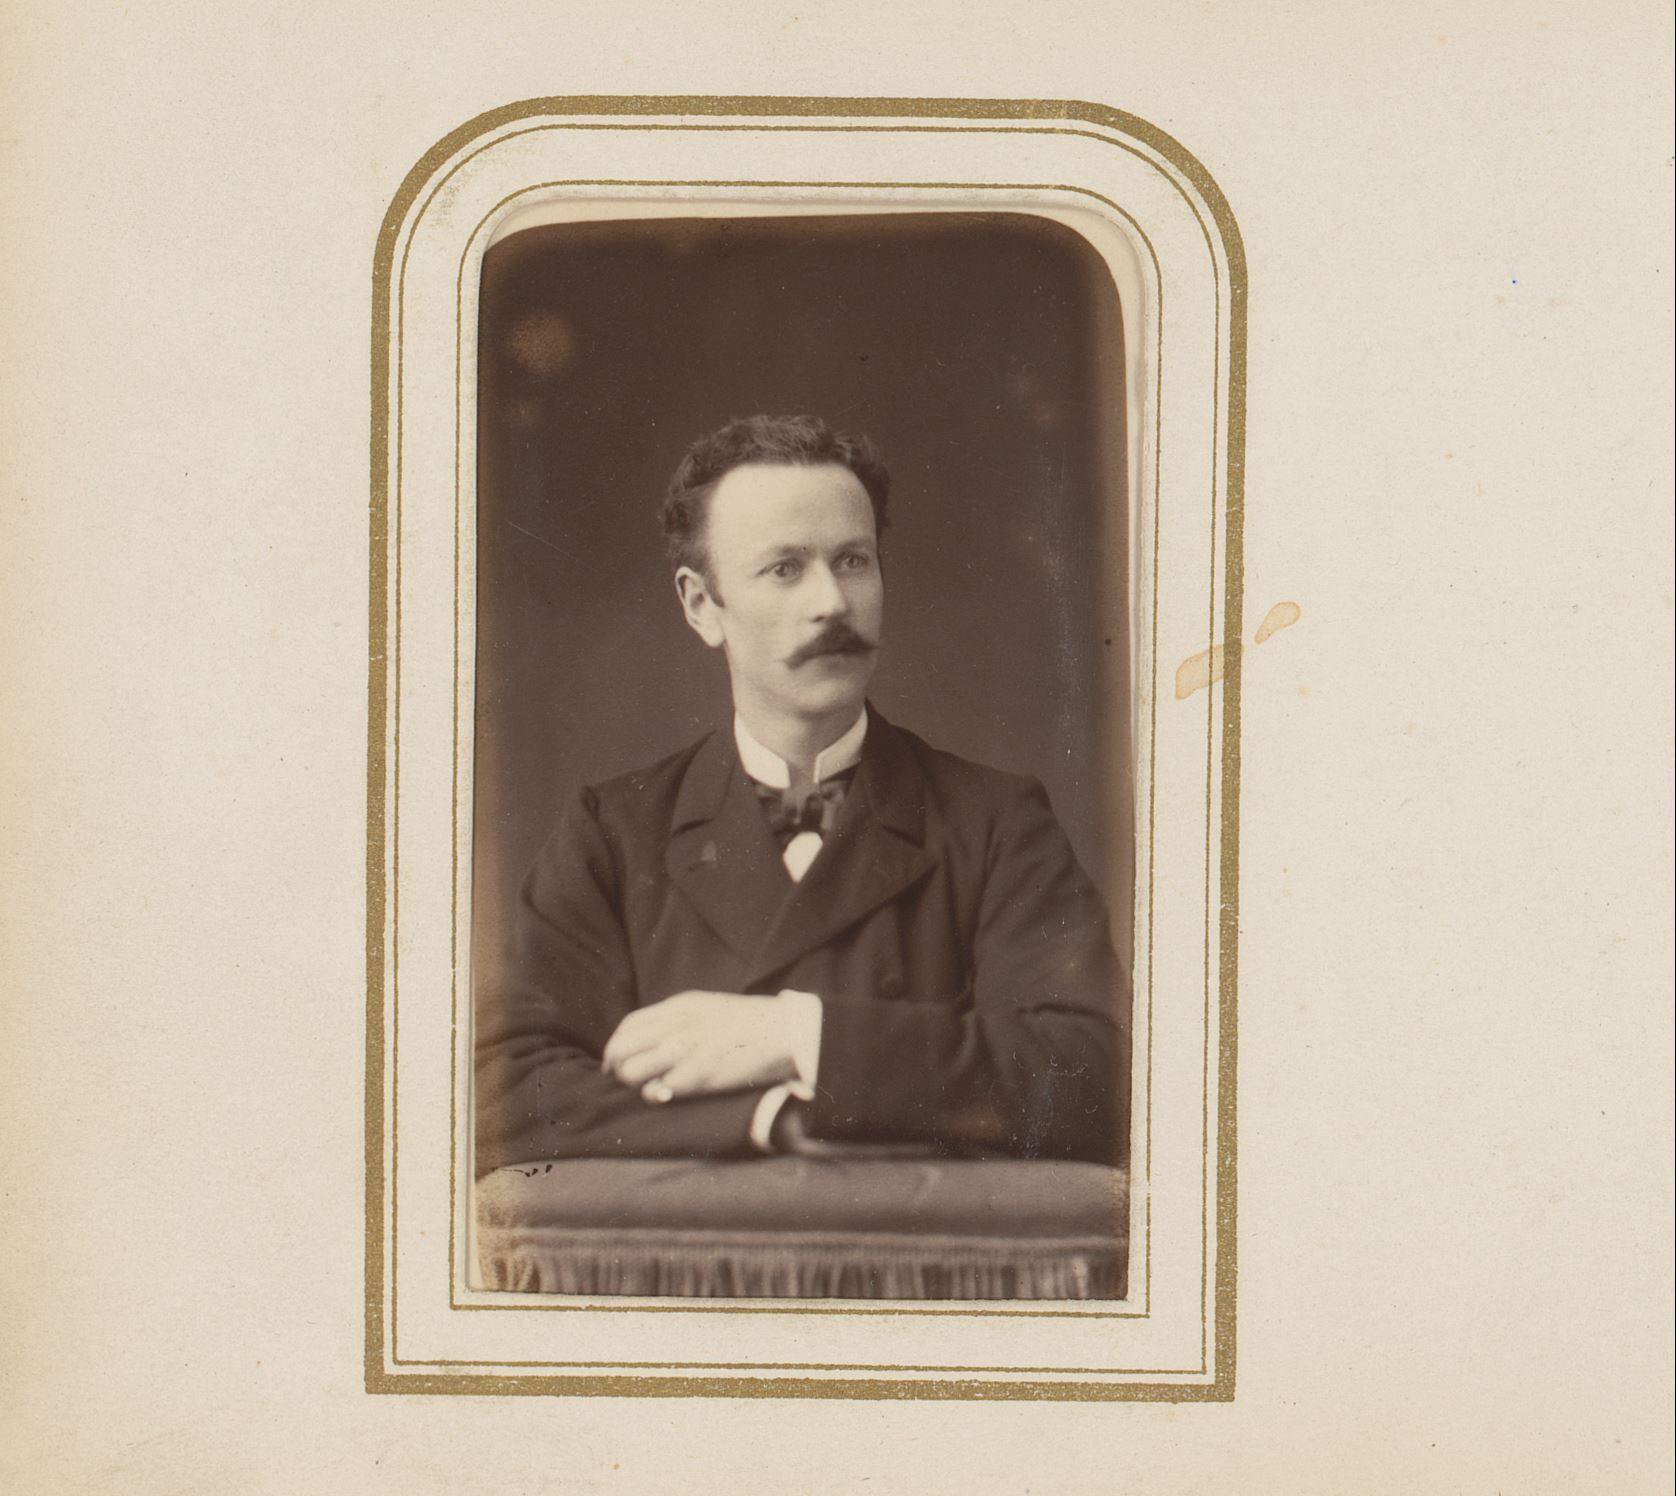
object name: photograph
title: Portret van een man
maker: auguste anfray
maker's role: publisher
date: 1860-1900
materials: cardboard, photographic support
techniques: albumen print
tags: moustache, adult man, historical persons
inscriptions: inscription: ‘Phototgraphie Centrale/ Anfray/ 31 Rue Croix des Petits Champs 31/ Paris (...)’